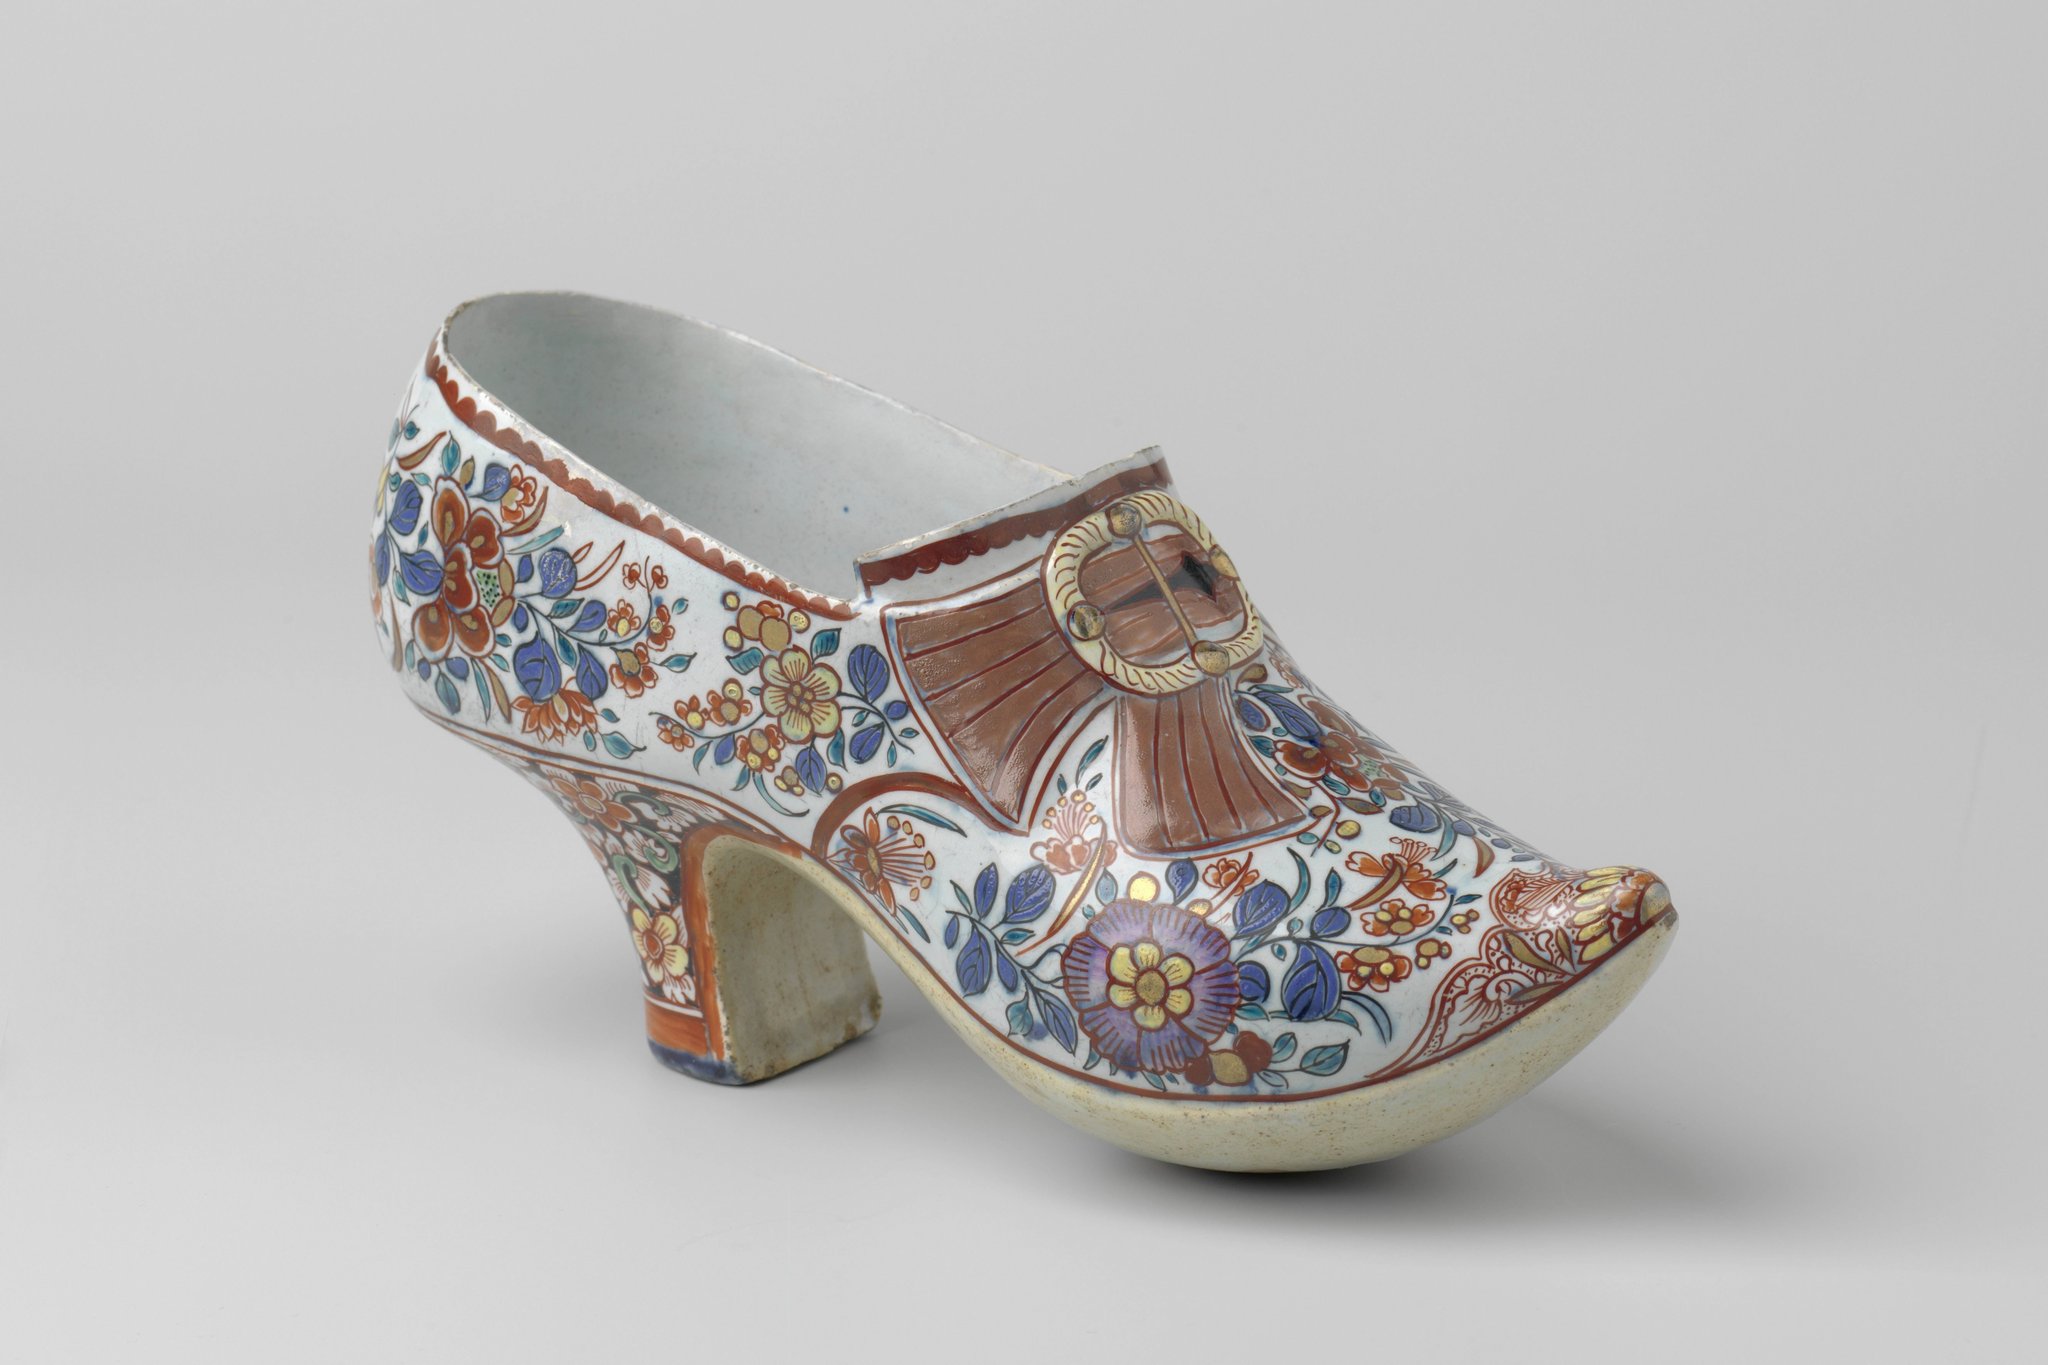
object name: shoe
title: Veelkleurig beschilderde schoen van faïence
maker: arie blankers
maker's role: plateelbakker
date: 1860-1890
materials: faience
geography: amsterdam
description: Schoen van faïence. Veelkleurig beschilderd met bloemdecoratie en strik met gesp. De veelkleurige beschildering is later aangebracht, waarschijnlijk 1860-1890.